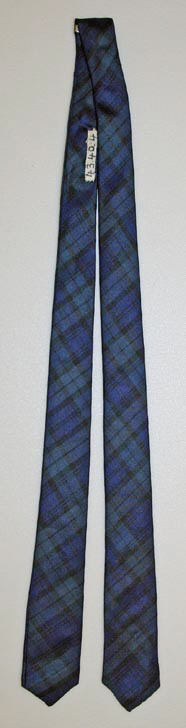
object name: necktie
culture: american or european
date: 1890-1899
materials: silk